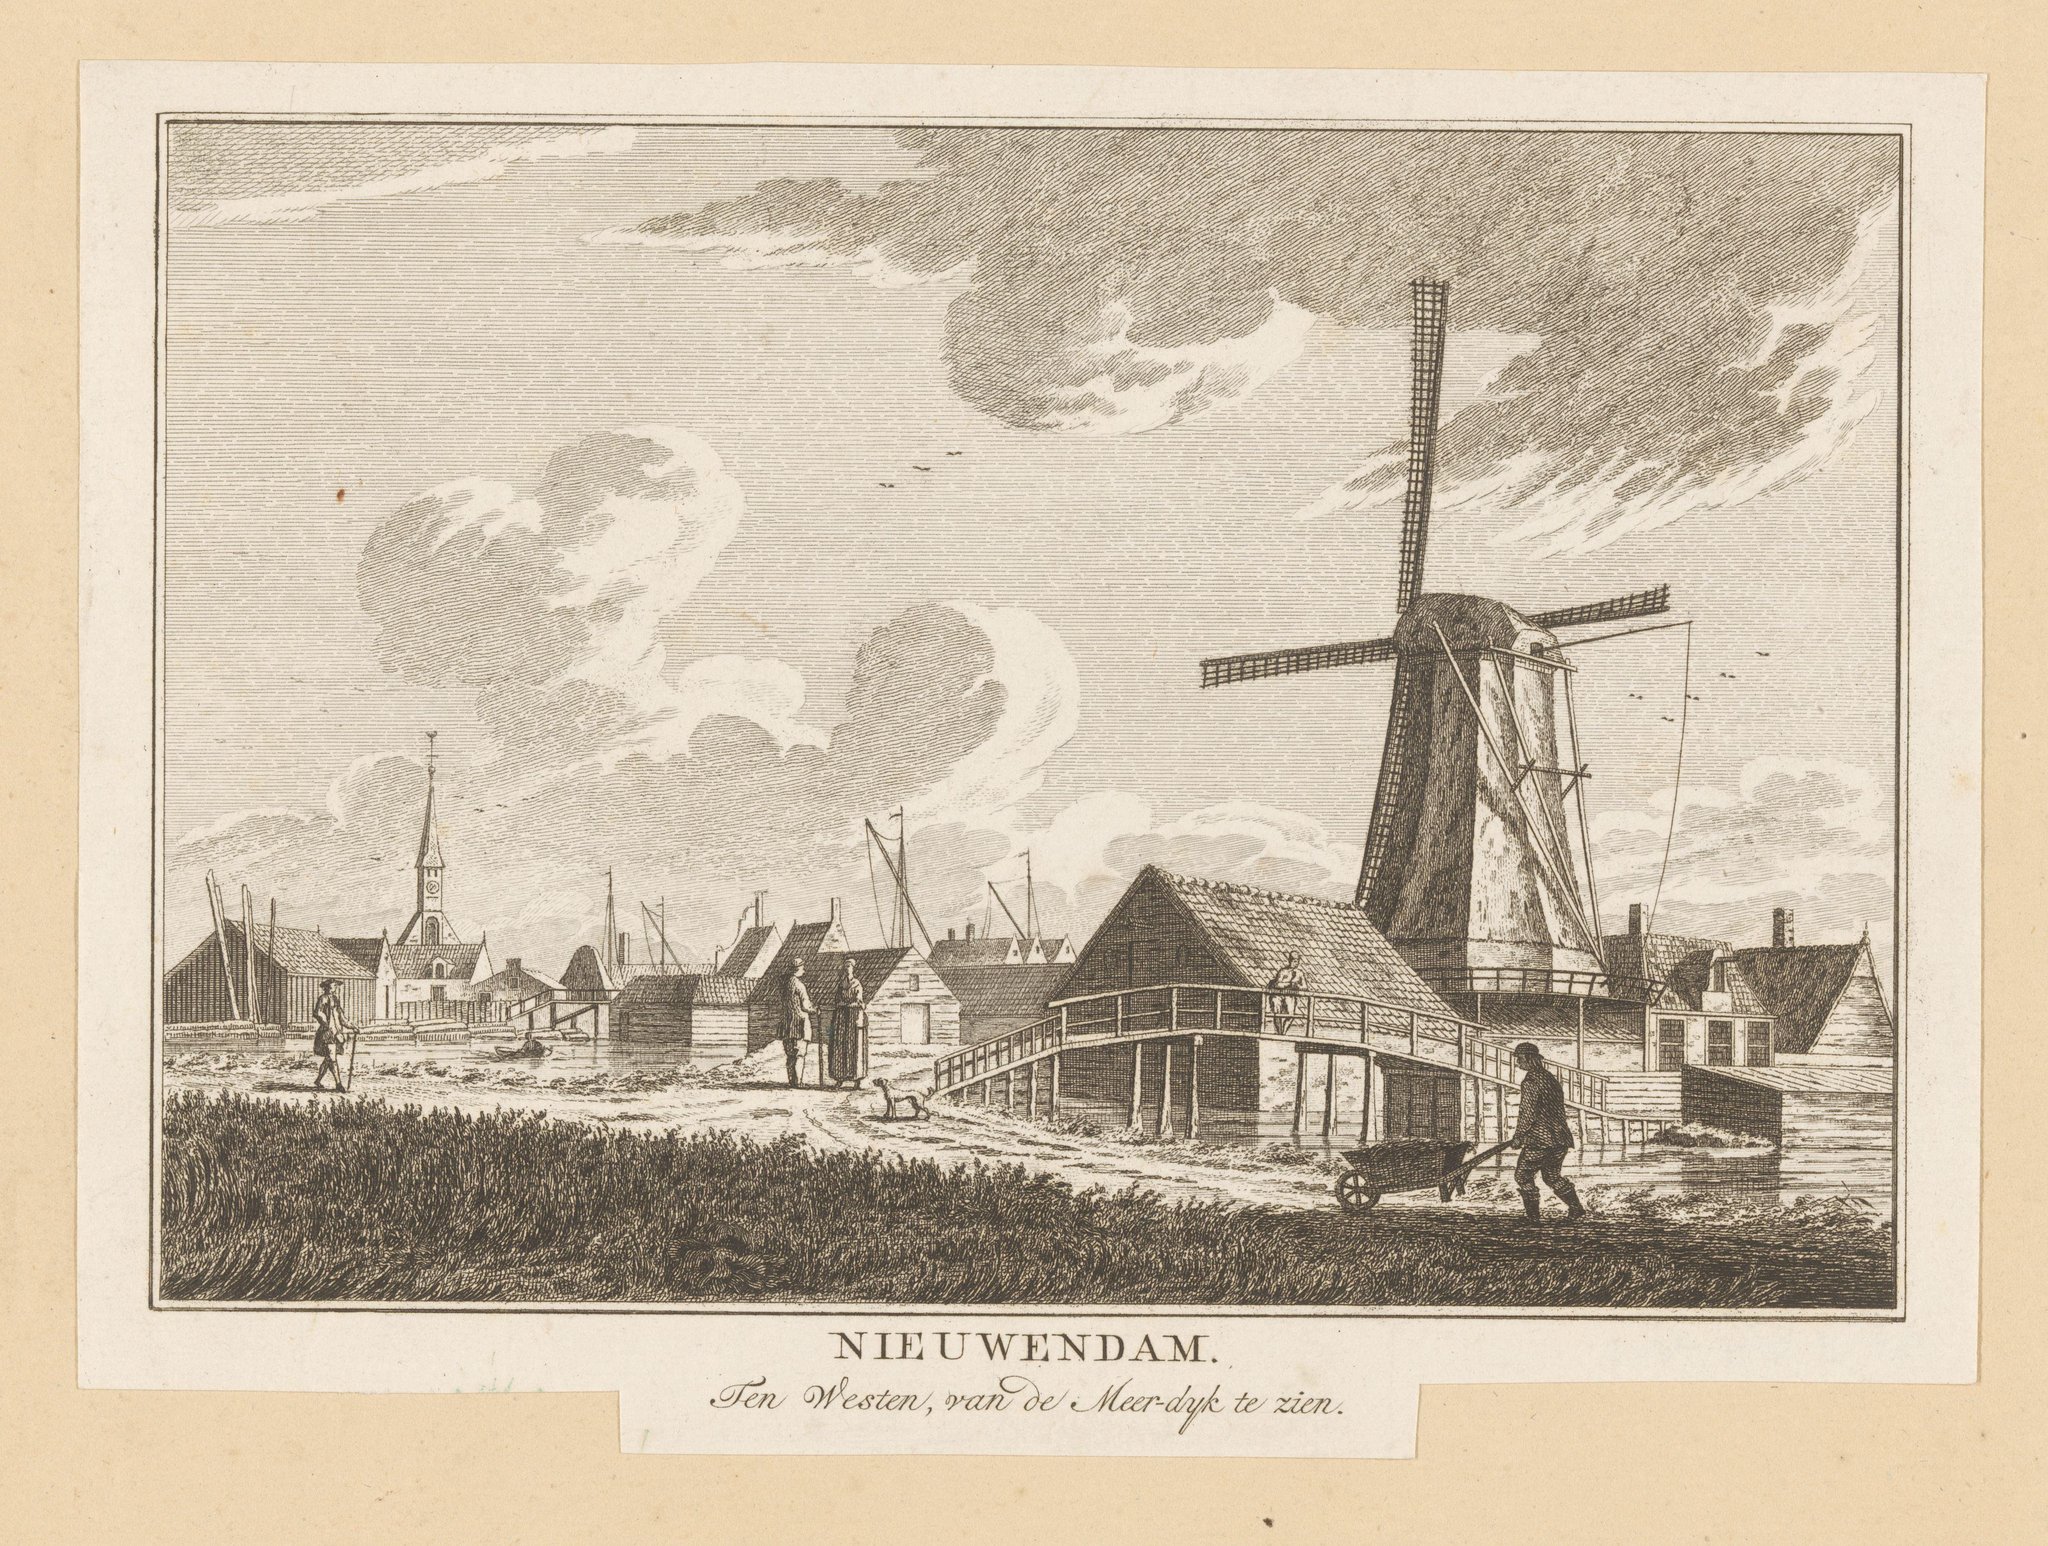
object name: print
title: Nieuwendam. Ten Westen, van de Meerdijk te zien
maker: carel frederik bendorp (i)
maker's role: print maker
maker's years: 1736-1814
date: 1786-1792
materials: paper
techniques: etching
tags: city-view, and landscape with man-made constructions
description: Prent eerst gebruikt in: Vaderlandsche gezichten, of afbeeldingen van den tegenwoordigen staat der Vereenigde Nederlanden (…). Amsterdam: Hendrik Gartman, Willem Vermandel en Jan Willem Smit, 1786-1792. Uitgegeven in afleveringen met ieder een eigen bifolium en inhoudsopgave. Alle prenten in deze publicatie zijn gegraveerd door Carel Frederik Bendorp (I) en, in de meeste gevallen, gebaseerd op tekeningen van Jan Bulthuis. Later is de prent uitgegeven als onderdeel van een plaatwerk uit ca. 1824-1825 met 74 (ongenummerde) platen van de belangrijkste topografische gezichten en verschillende zeden en gewoonten in het Verenigd Koninkrijk der Nederlanden, getiteld 'Tableau des principales vues des palais et édifices : représentations et des coutumes et usages, dans les provinces septentrionales du Royaume des Pays-Bas'. Bij de andere prenten uit 'Vaderlandsche gezichten' die zijn hergebruikt voor dit plaatwerk is een tweede Franse titel toegevoegd, waardoor er sprake is van twee verschillende staten. Het is onduidelijk of dat voor deze prent ook geldt. Daarmee is het ook onduidelijk of het huidige exemplaar is uitgegeven als onderdeel van 'Vaderlandsche gezichten' of als onderdeel van het plaatwerk.